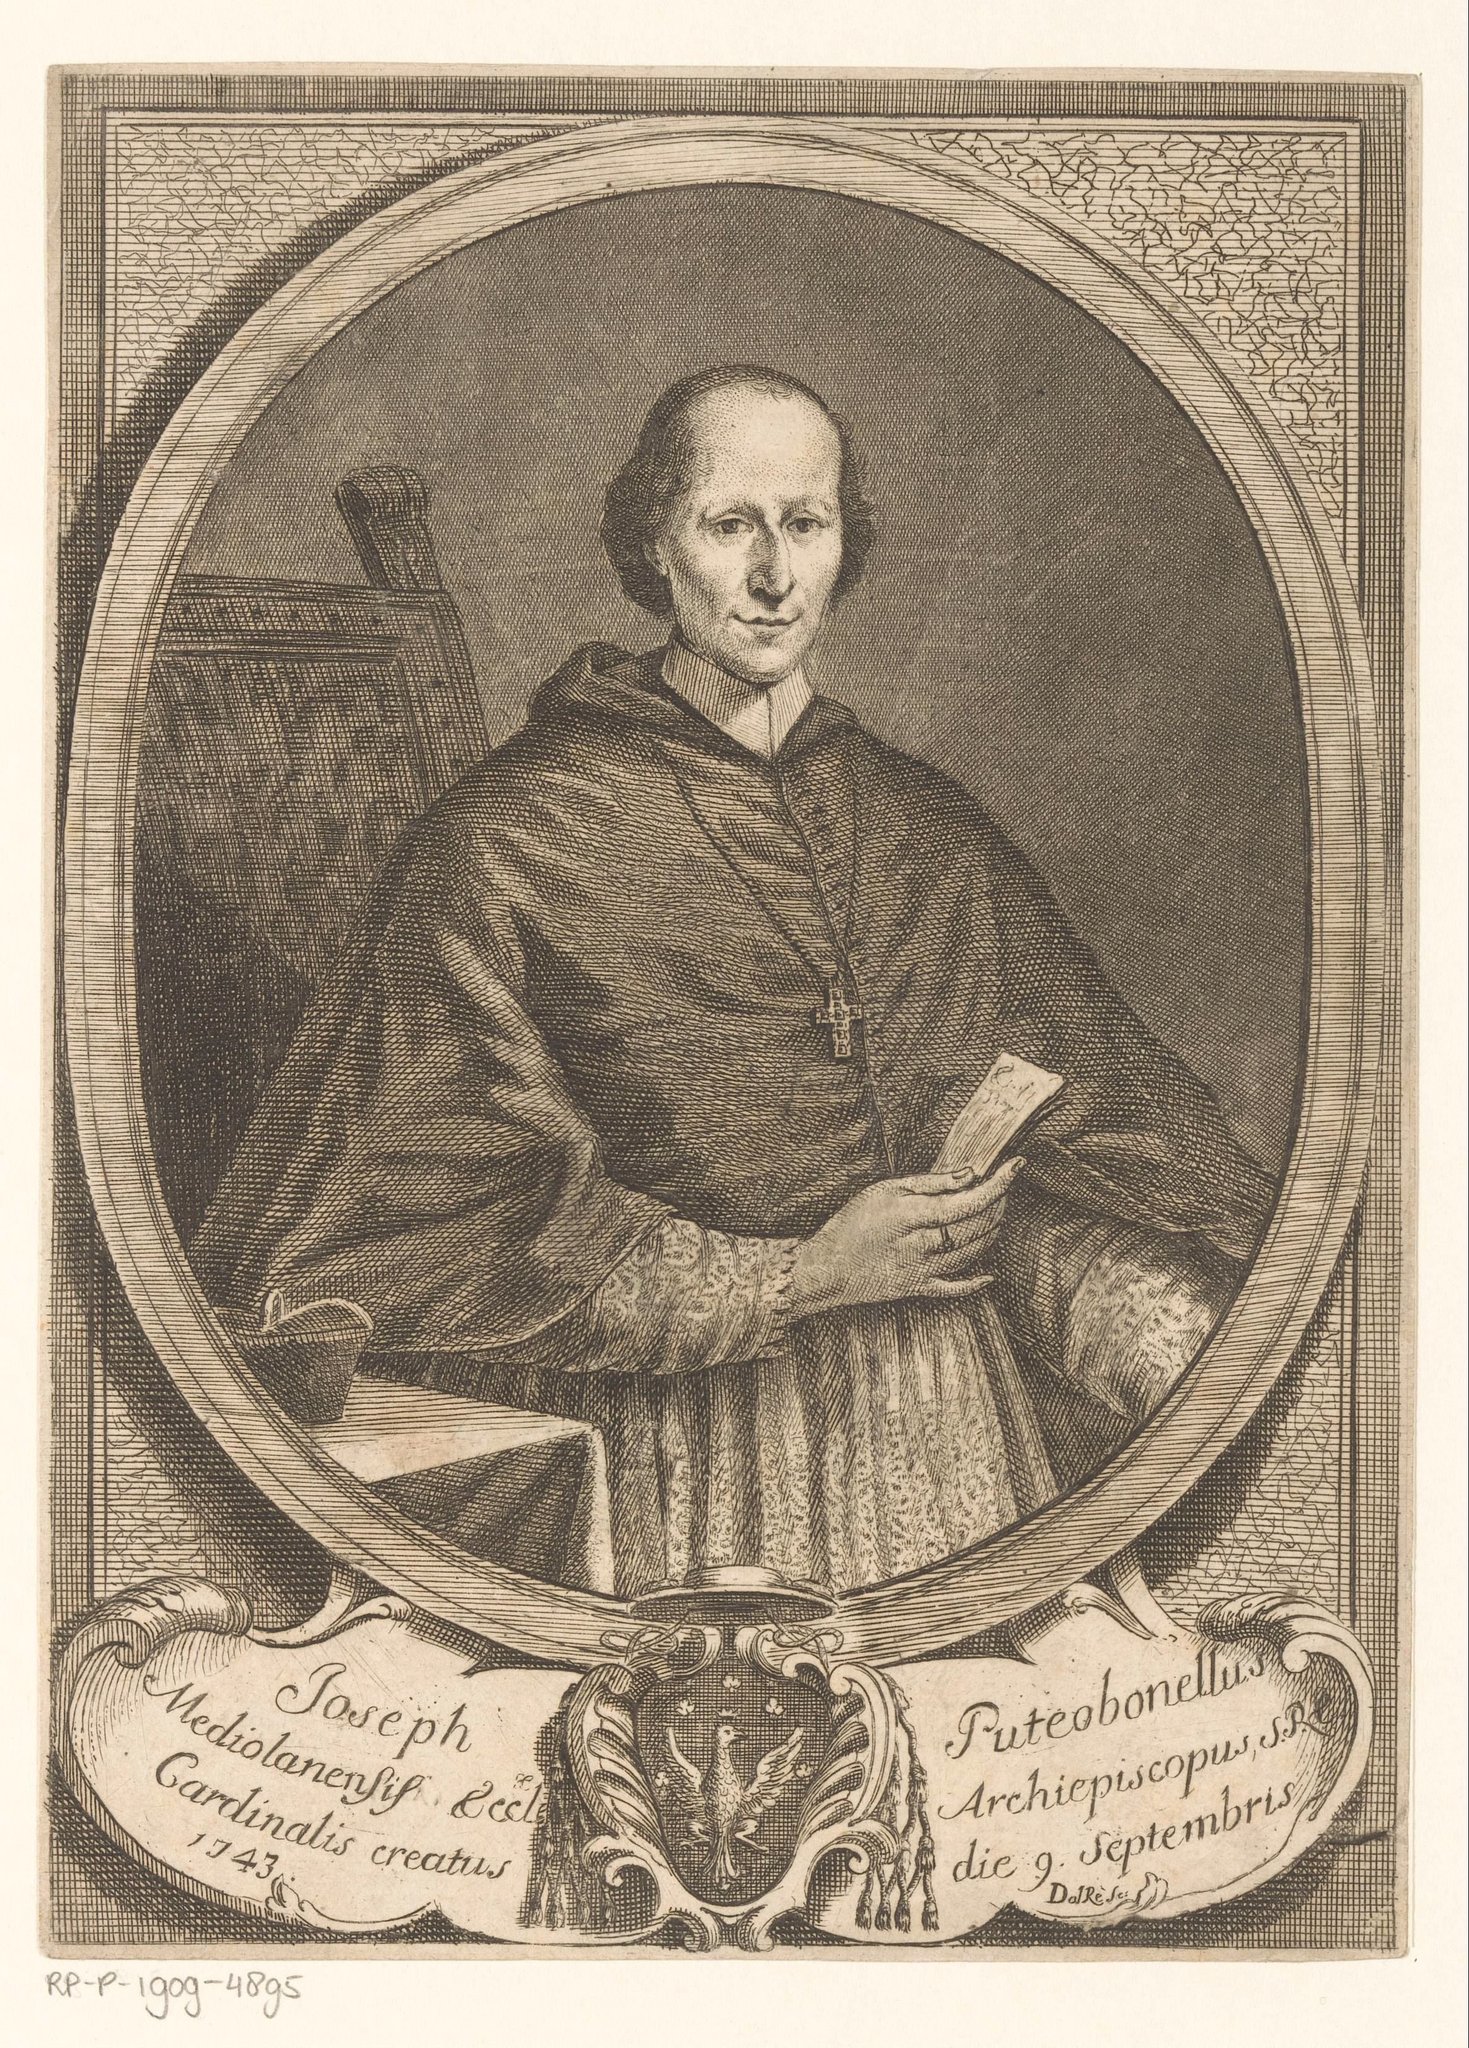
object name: print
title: Portret van kardinaal Giuseppe Pozzobonelli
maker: marc antonio dal re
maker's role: print maker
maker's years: 1697-1766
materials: paper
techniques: engraving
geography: italy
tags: giuseppe pozzobonelli, cardinal, historical persons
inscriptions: collector's mark: Lugt 2228